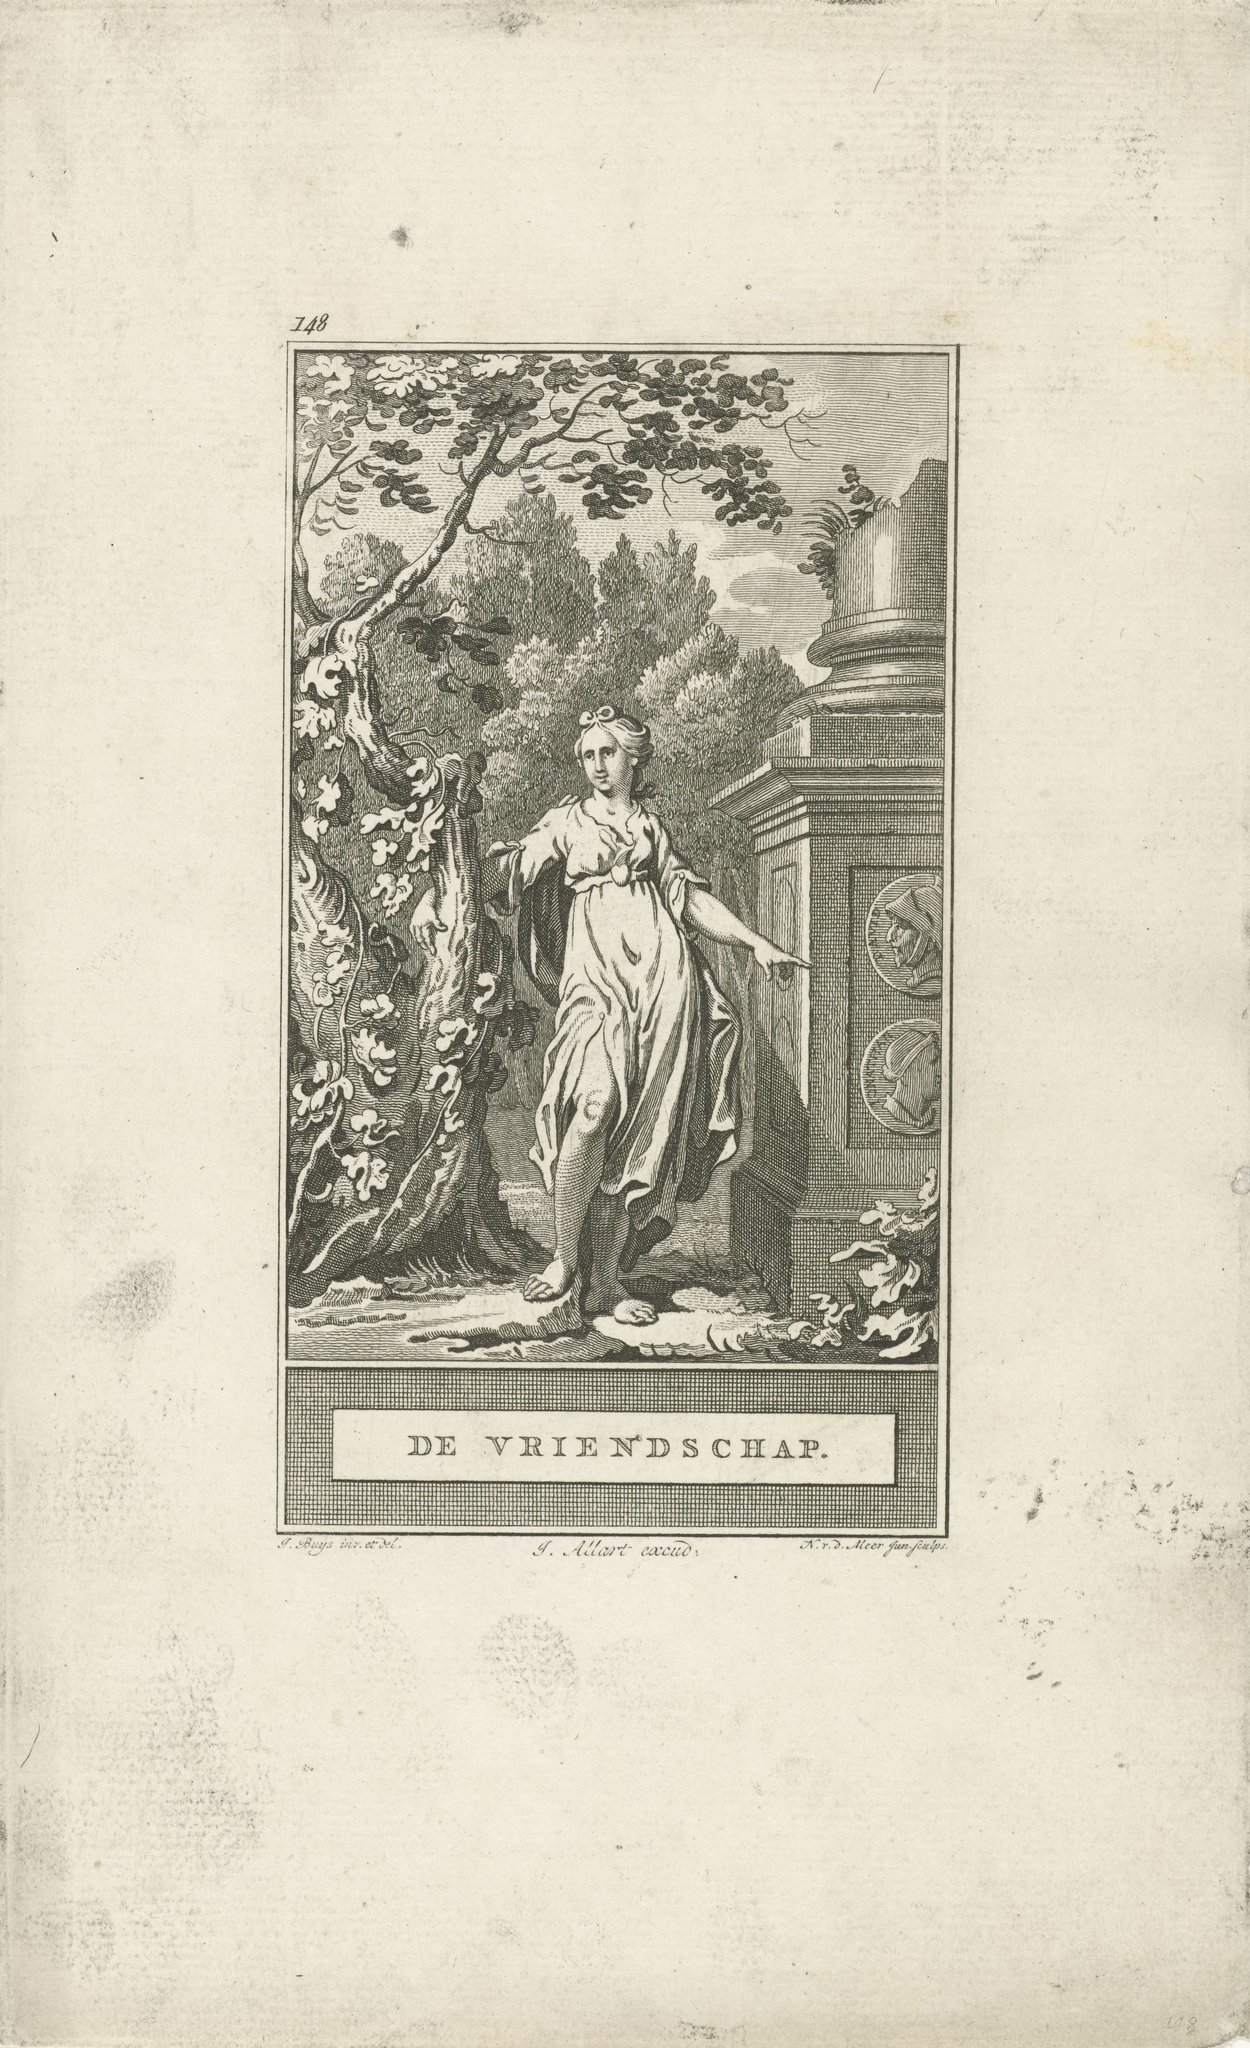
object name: print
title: Vriendschap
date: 1778-1785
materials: paper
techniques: etching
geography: amsterdam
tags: friendship; 'amicitia' (ripa) (+ personification), david and jonathan (1 samuel 20)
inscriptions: collector's mark: Lugt 2228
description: Prent bij: Gellert, Christian Fürchtegott. Fabelen en vertelsels. 3 dln. Amsterdam: Pieter Meyer, 1772-1774. De prenten bij deze publicatie werden later uitgegeven. De exemplaren uitgegeven door de weduwe Jacobus Loveringh & Johannes Allart tussen 1777 en 1778, de exemplaren uitgegeven door alleen Johannes Allart tussen 1778 en 1785.